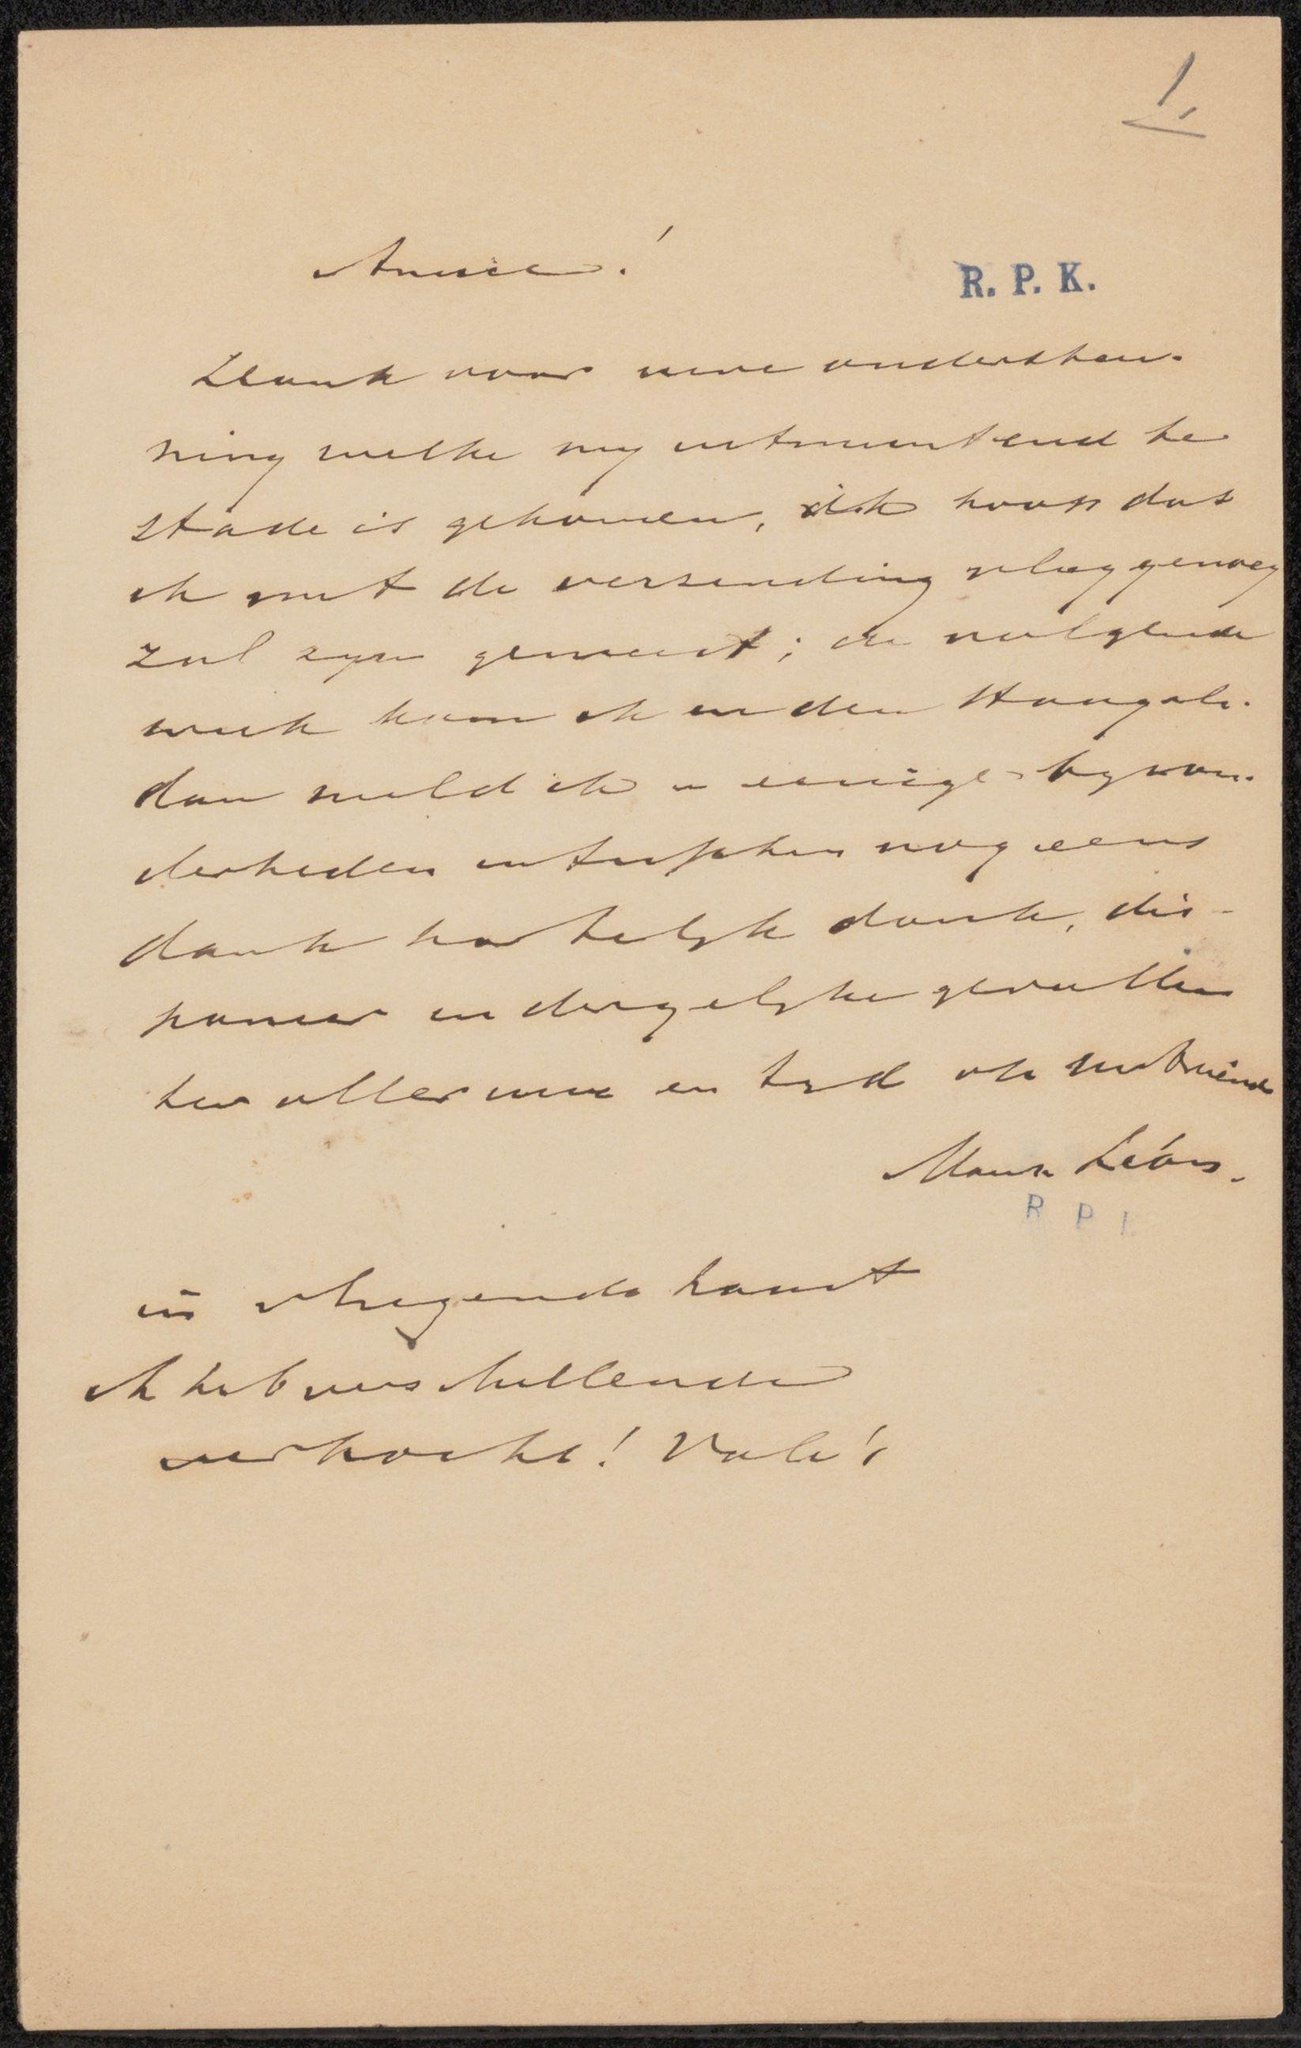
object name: letter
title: Brief aan anoniem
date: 1848-1865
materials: ink, paper, pencil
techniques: pen, writing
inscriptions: collector's mark: Lugt 2233